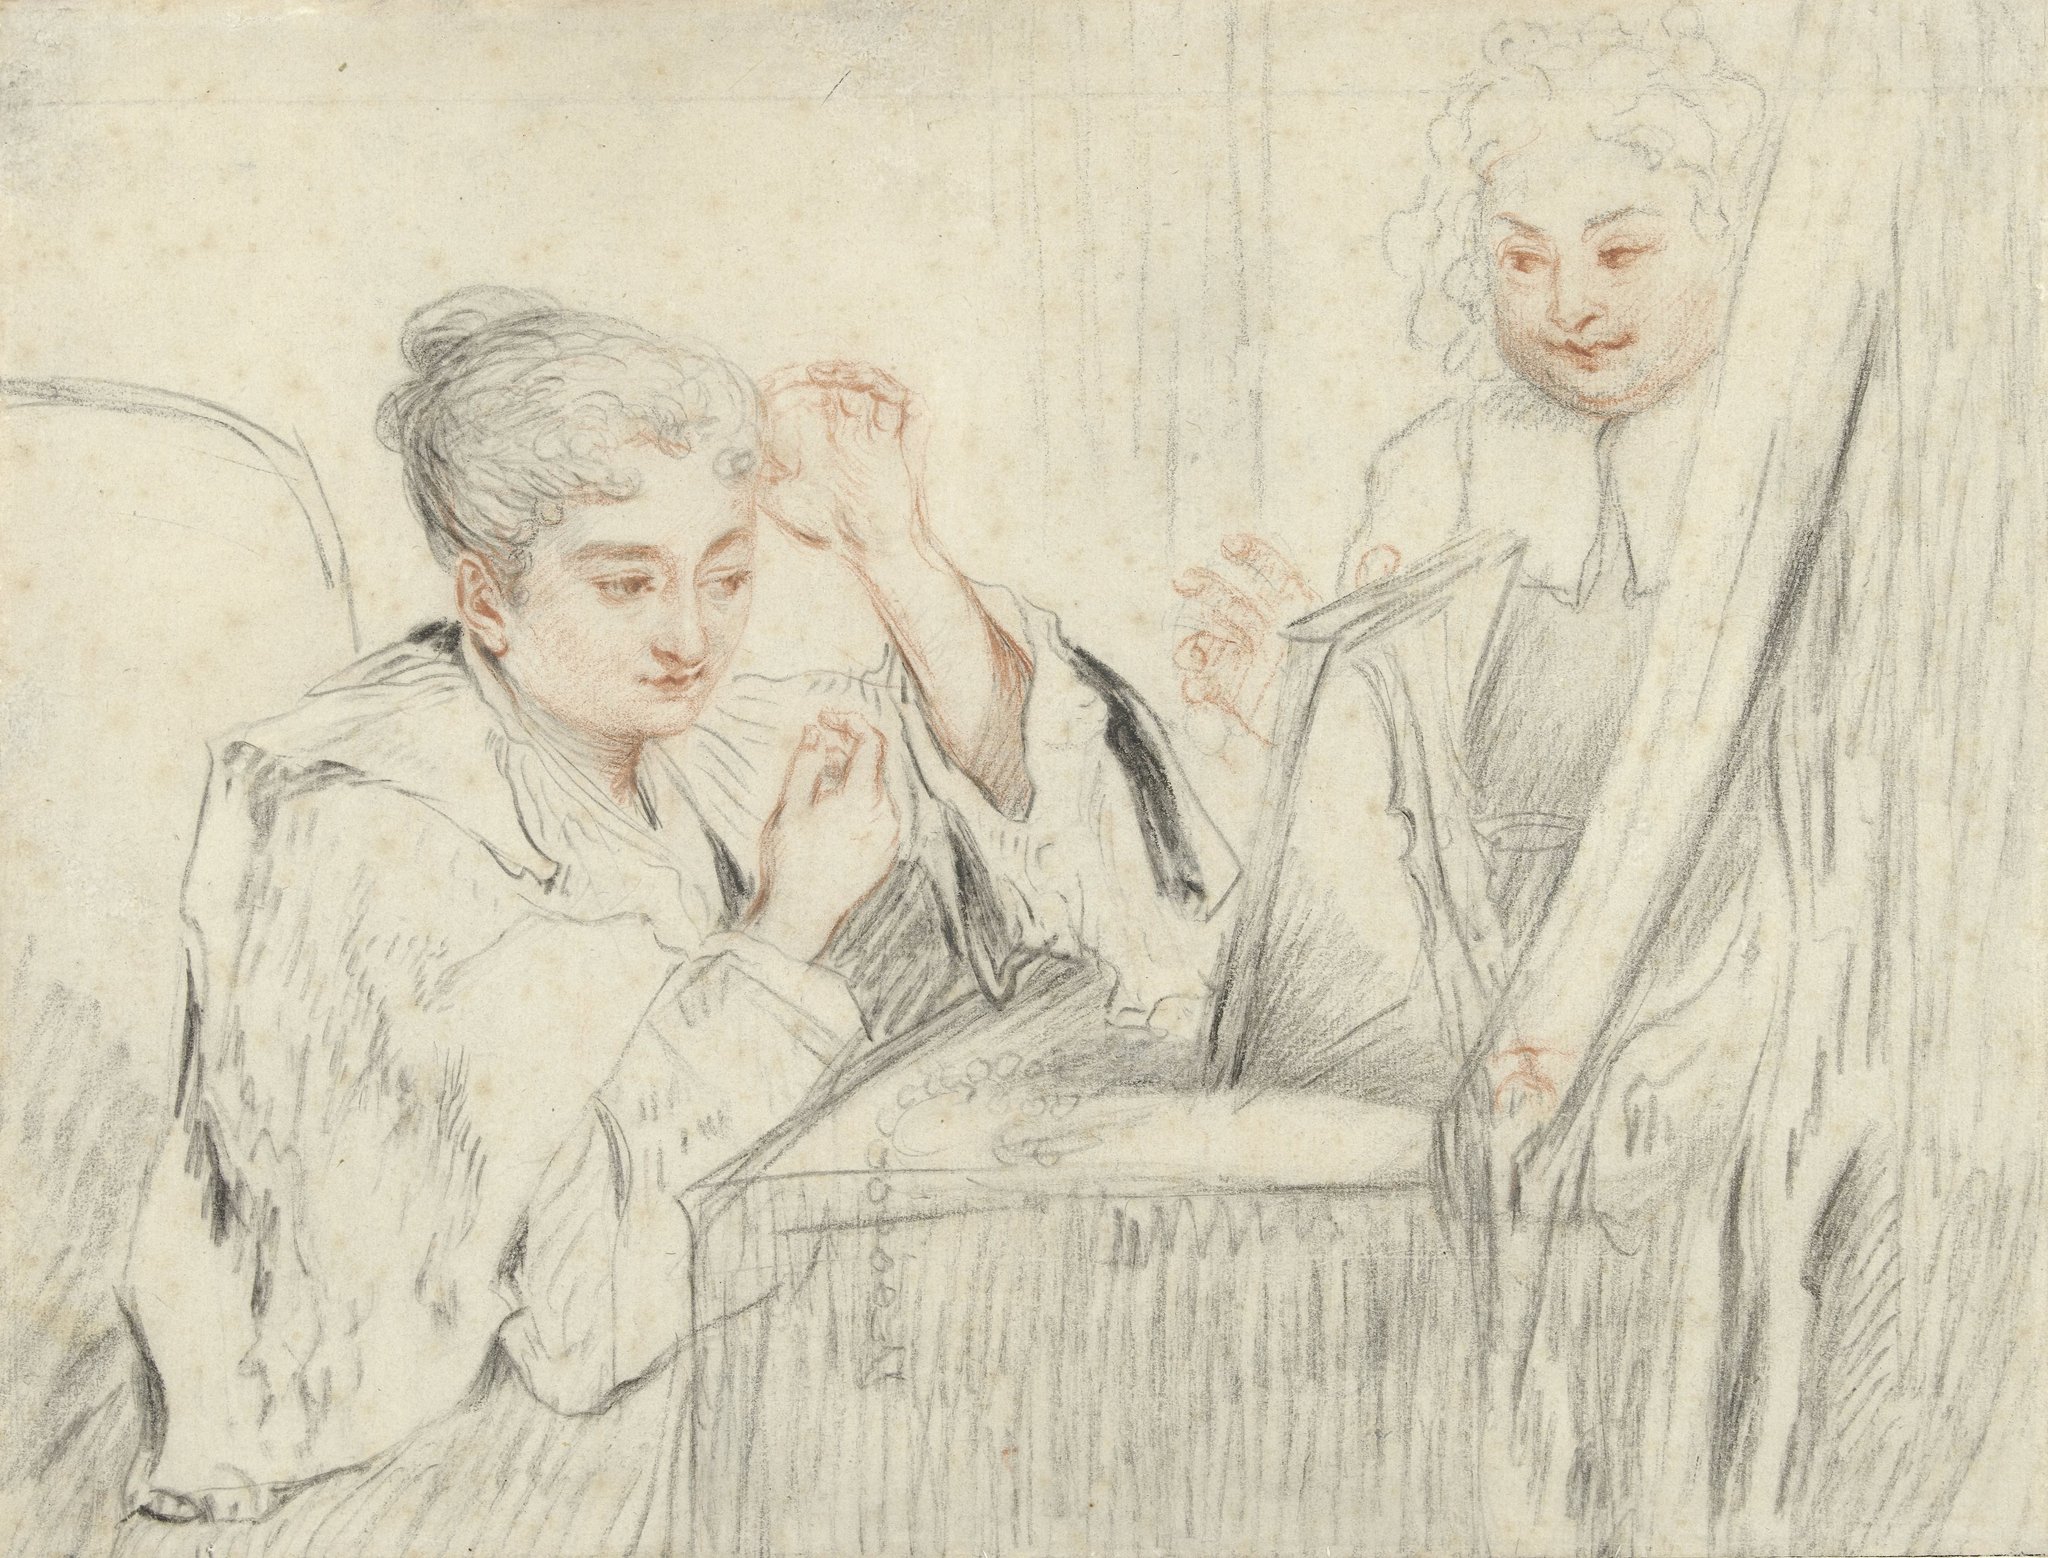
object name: drawing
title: Rosalba Carriera (?) aan haar toilet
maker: jean antoine watteau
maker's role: draughtsman, print maker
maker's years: 1684-1721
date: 1721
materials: chalk, paper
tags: venice, painter, rosalba carriera, making toilet, mirror - aa - (for) women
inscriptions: collector's mark: Lugt 2228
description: Dame aan haar kaptafel, een abbé ziet toe.